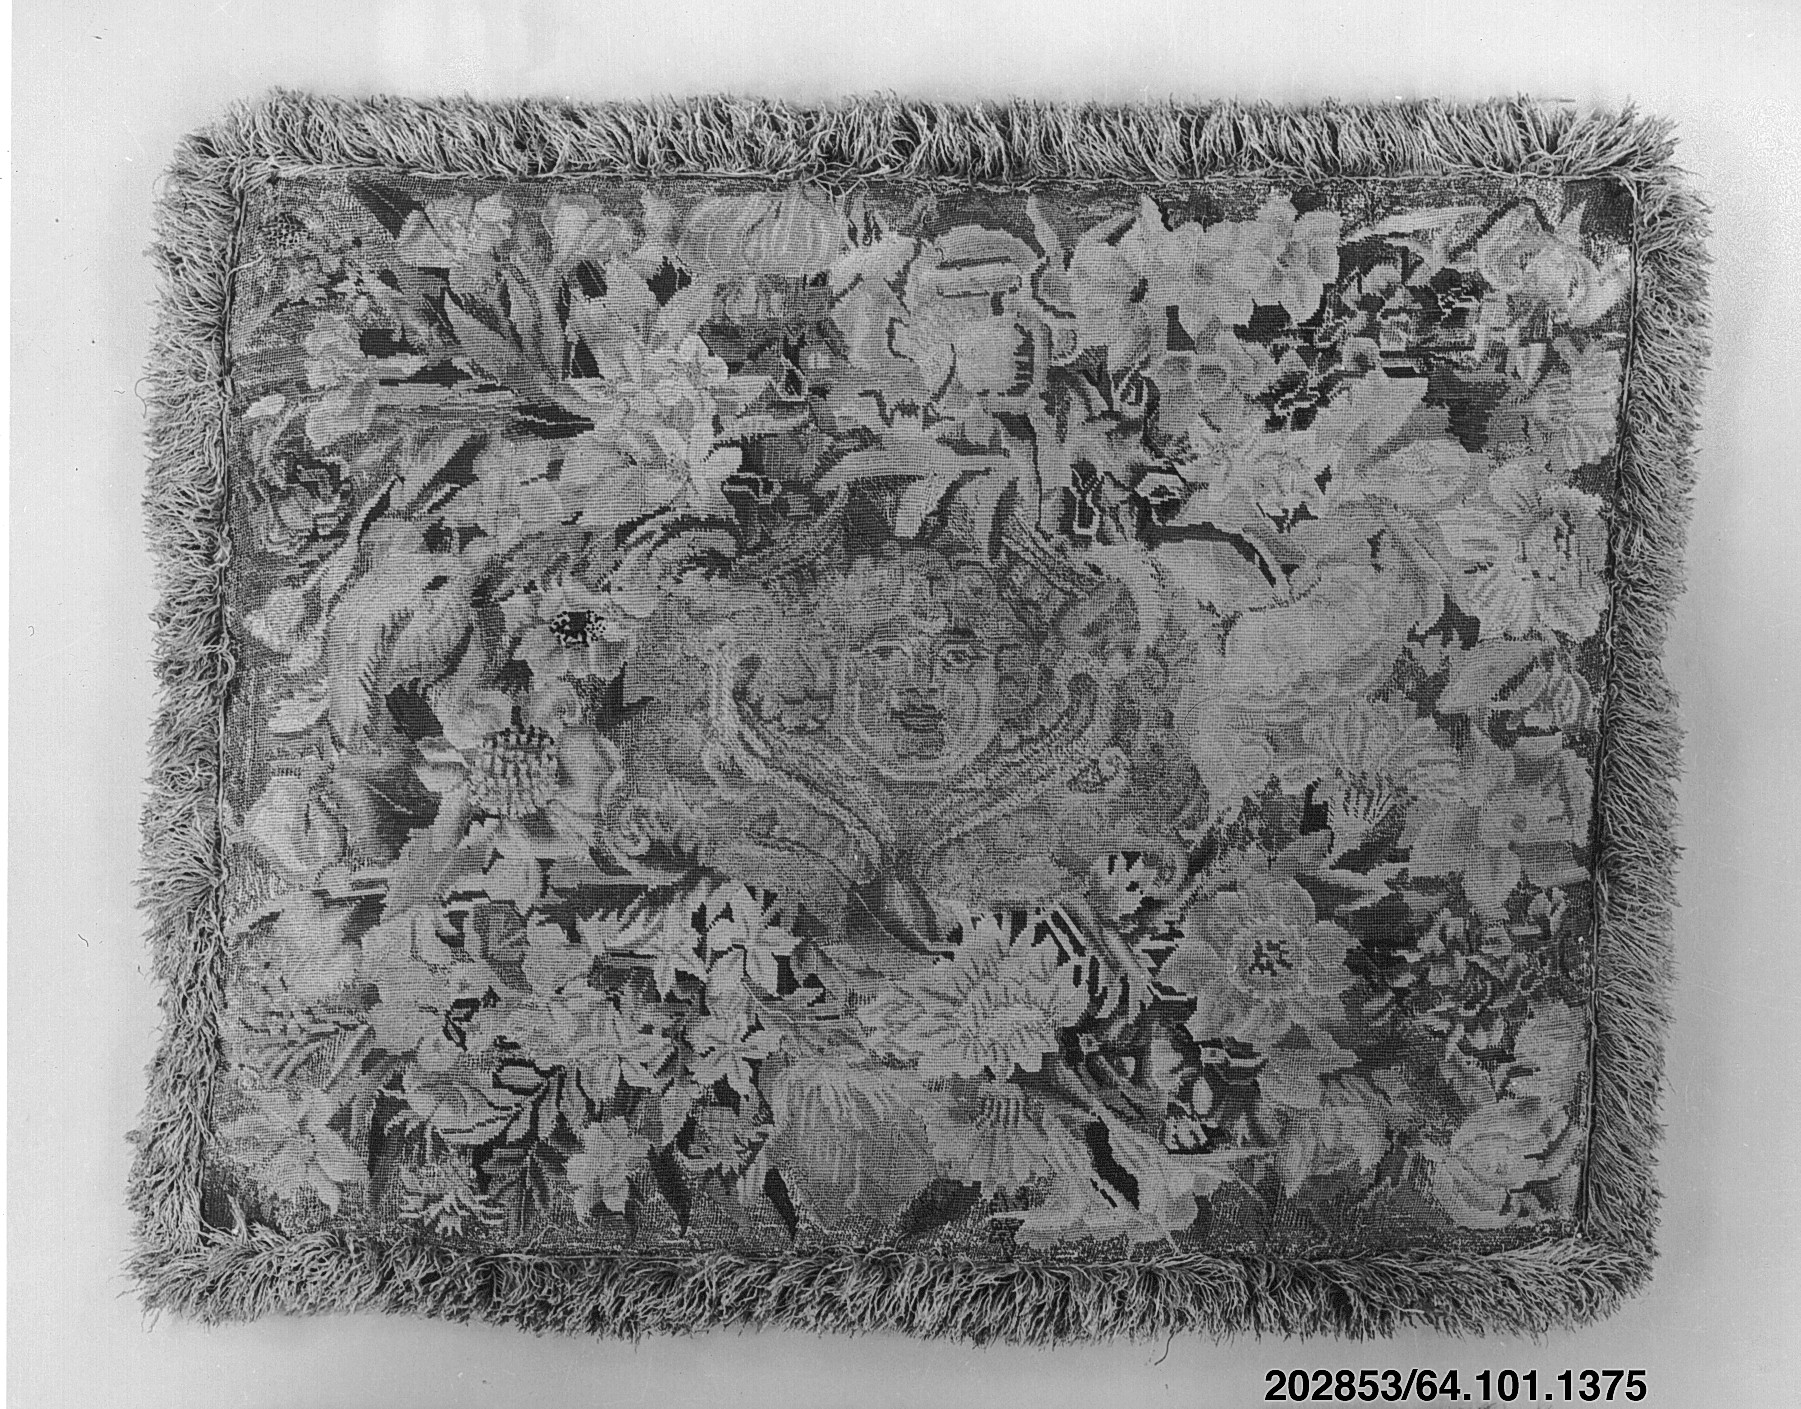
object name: cushion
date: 1601-1625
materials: canvas, metal thread, silk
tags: faces,flowers